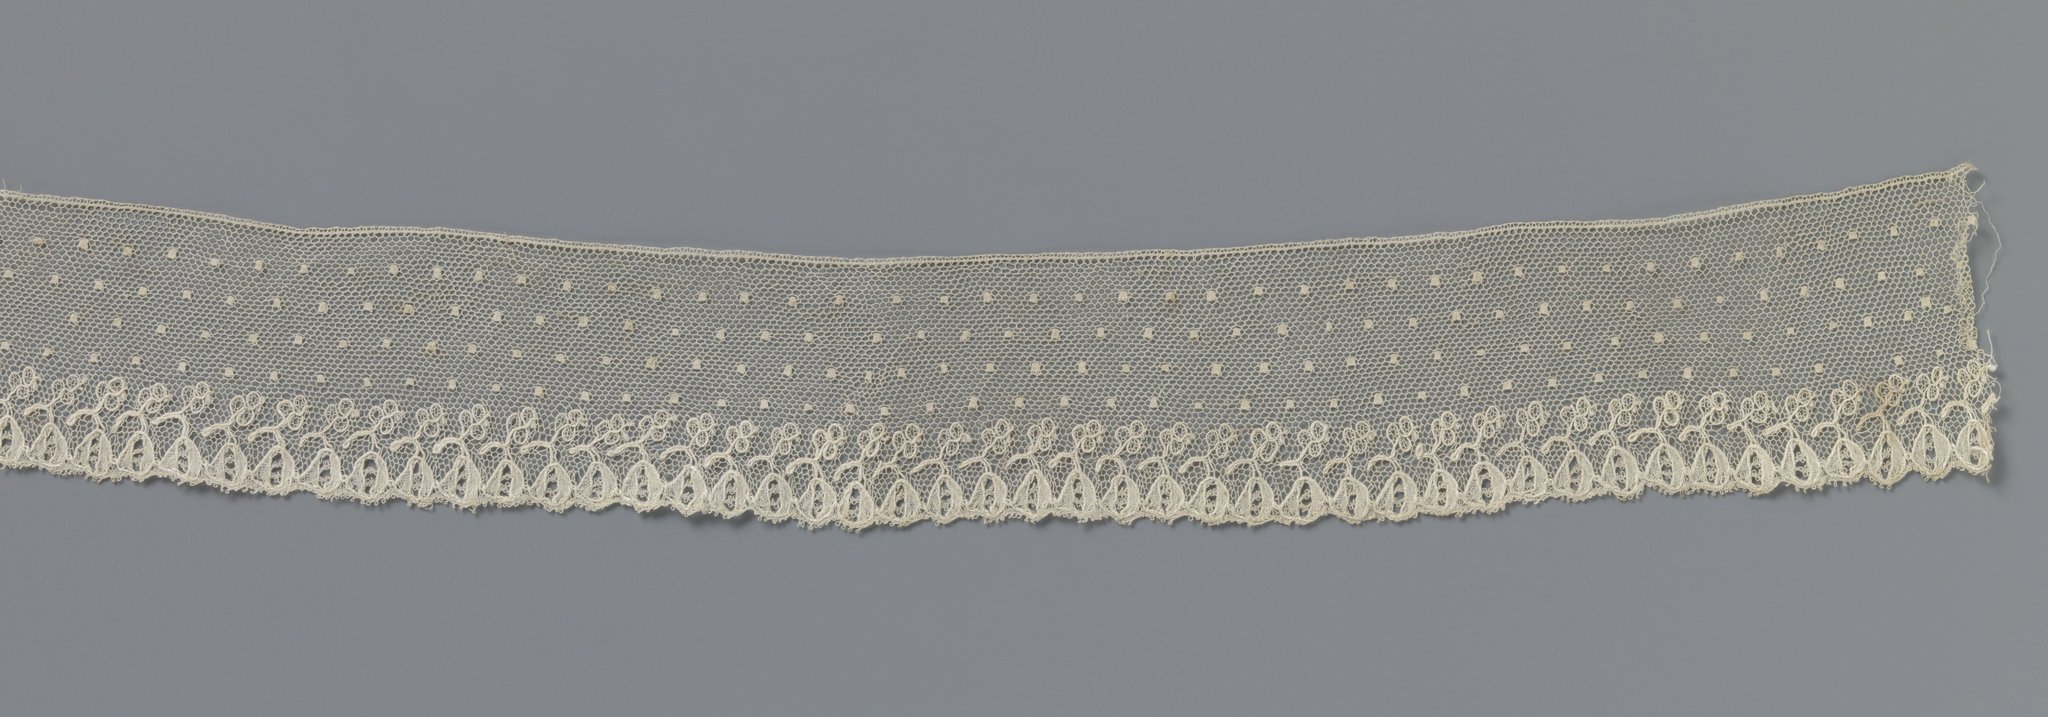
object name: strip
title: Strook kloskant met hangende kelkbloempjes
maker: Anonymous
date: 1820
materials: linen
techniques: lace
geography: southern netherlands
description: Strook naturelkleurige kloskant: Rijselse kant. Onder een strooipatroon van vierkante moesjes bestaat het zich herhalende patroon uit een hangend kelkbloempje, aan een gebogen steeltje met drie ronde blaadjes. De kelkbloempjes zijn tegen elkaar aan geplaatst en vormen de schulpjes langs de onderzijde van de strook. De motieven zijn met elkaar verbonden door een fijne traliegrond, een tulegrond. Het volwerk in de kelkbloem is gemaakt in linnenslag, met een opengewerkte middenbaan en voorzien van dikkere en glimmende contourdraden. Het steeltje en de blaadjes zijn gemaakt met contourdraden waarbij in de blaadjes een siergrond is gebruikt. De moesjes zijn gemaakt in vormslag. De bovenzijde van de strook is recht afgewerkt. De schulpjes langs de onderzijde zijn afgewerkt met picots.